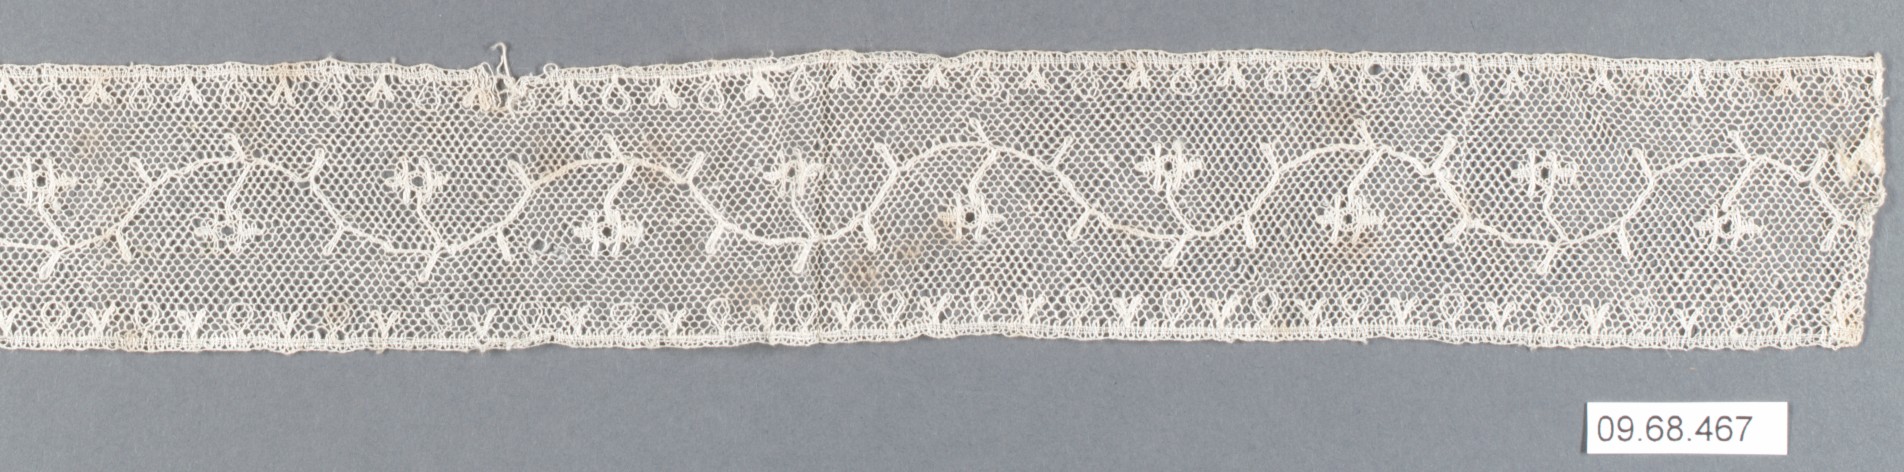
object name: insertion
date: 1801-1900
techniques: lace